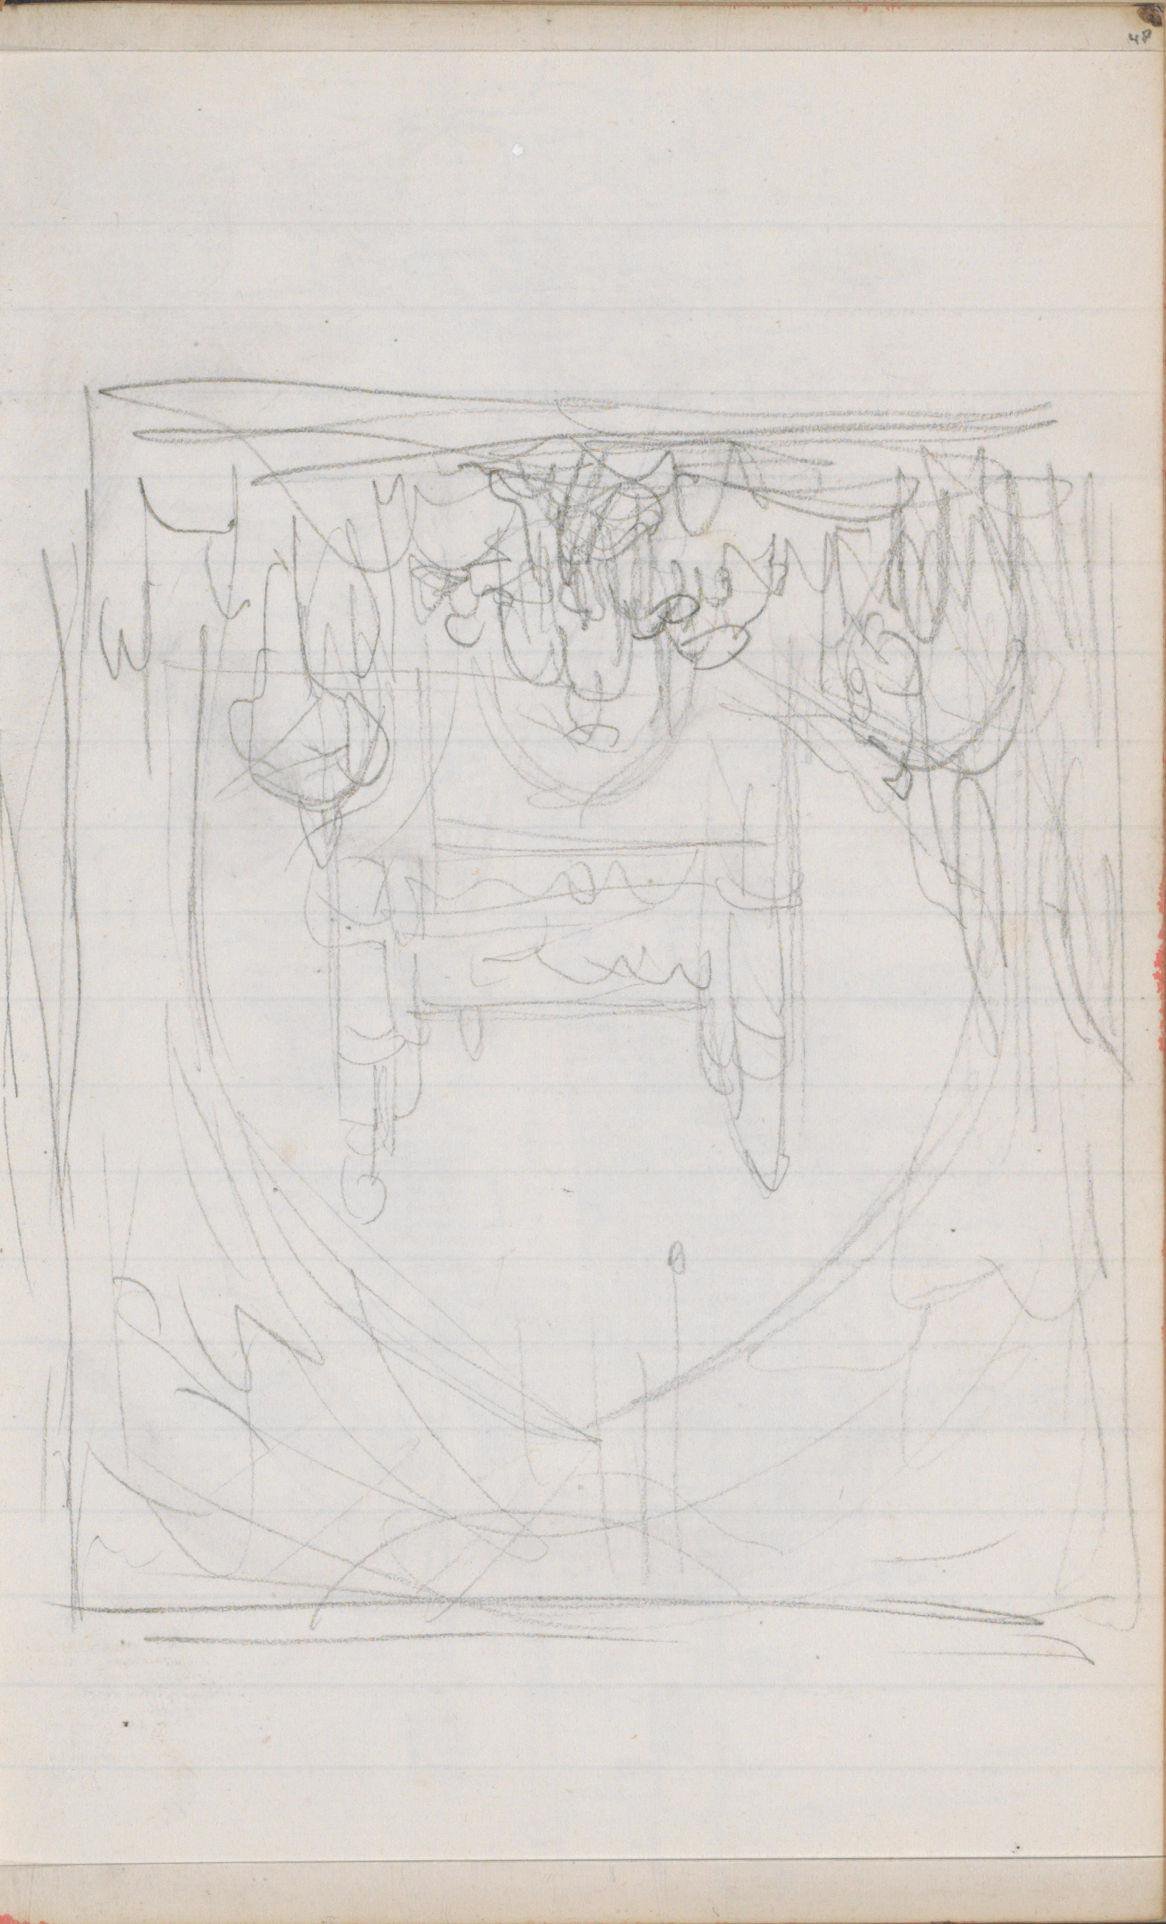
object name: sketchbook leaf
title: Straat met poorten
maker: marius bauer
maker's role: draughtsman, print maker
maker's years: 1867-1932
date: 1897-1898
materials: pencil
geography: india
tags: arch, archivolt ~ architecture, trunked animals: elephant, street (+ city(-scape) with figures, staffage)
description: Op de straat zijn enkele figuren en een olifant te zien. Pagina 48 uit een schetsboek met 62 bladen.